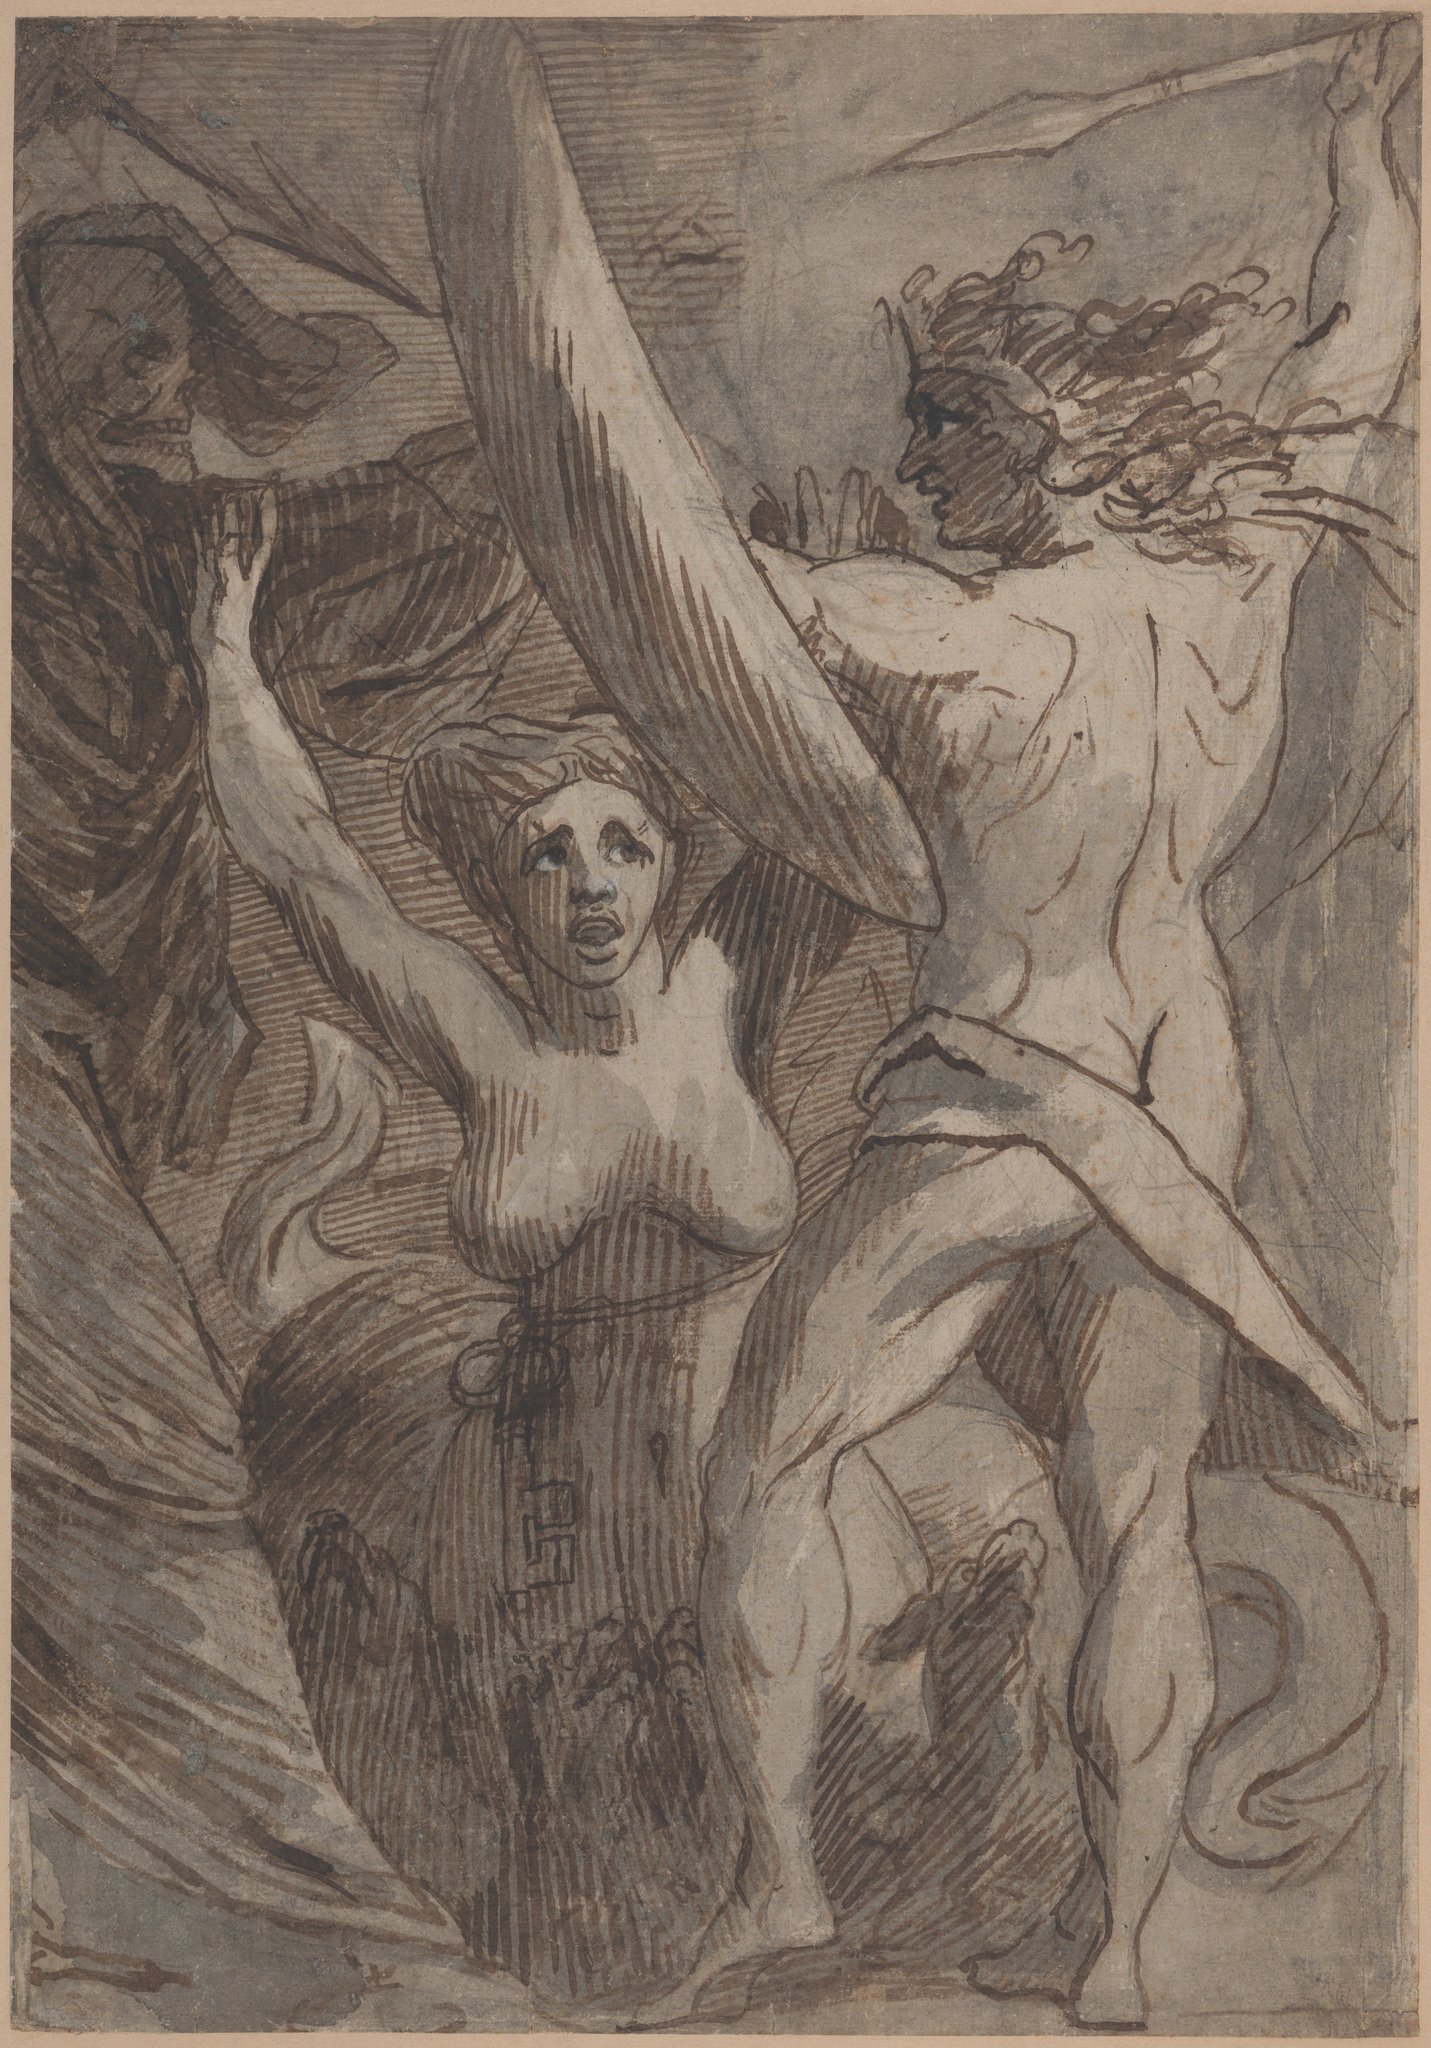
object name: drawing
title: Satan, Sin, and Death: "Death and Sin met by Satan on his Return from Earth"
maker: james barry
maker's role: artist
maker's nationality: irish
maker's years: 1741-1806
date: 1792-1795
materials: graphite, ink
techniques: brush, heightening, wash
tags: spears,skeletons,female nudes,devil